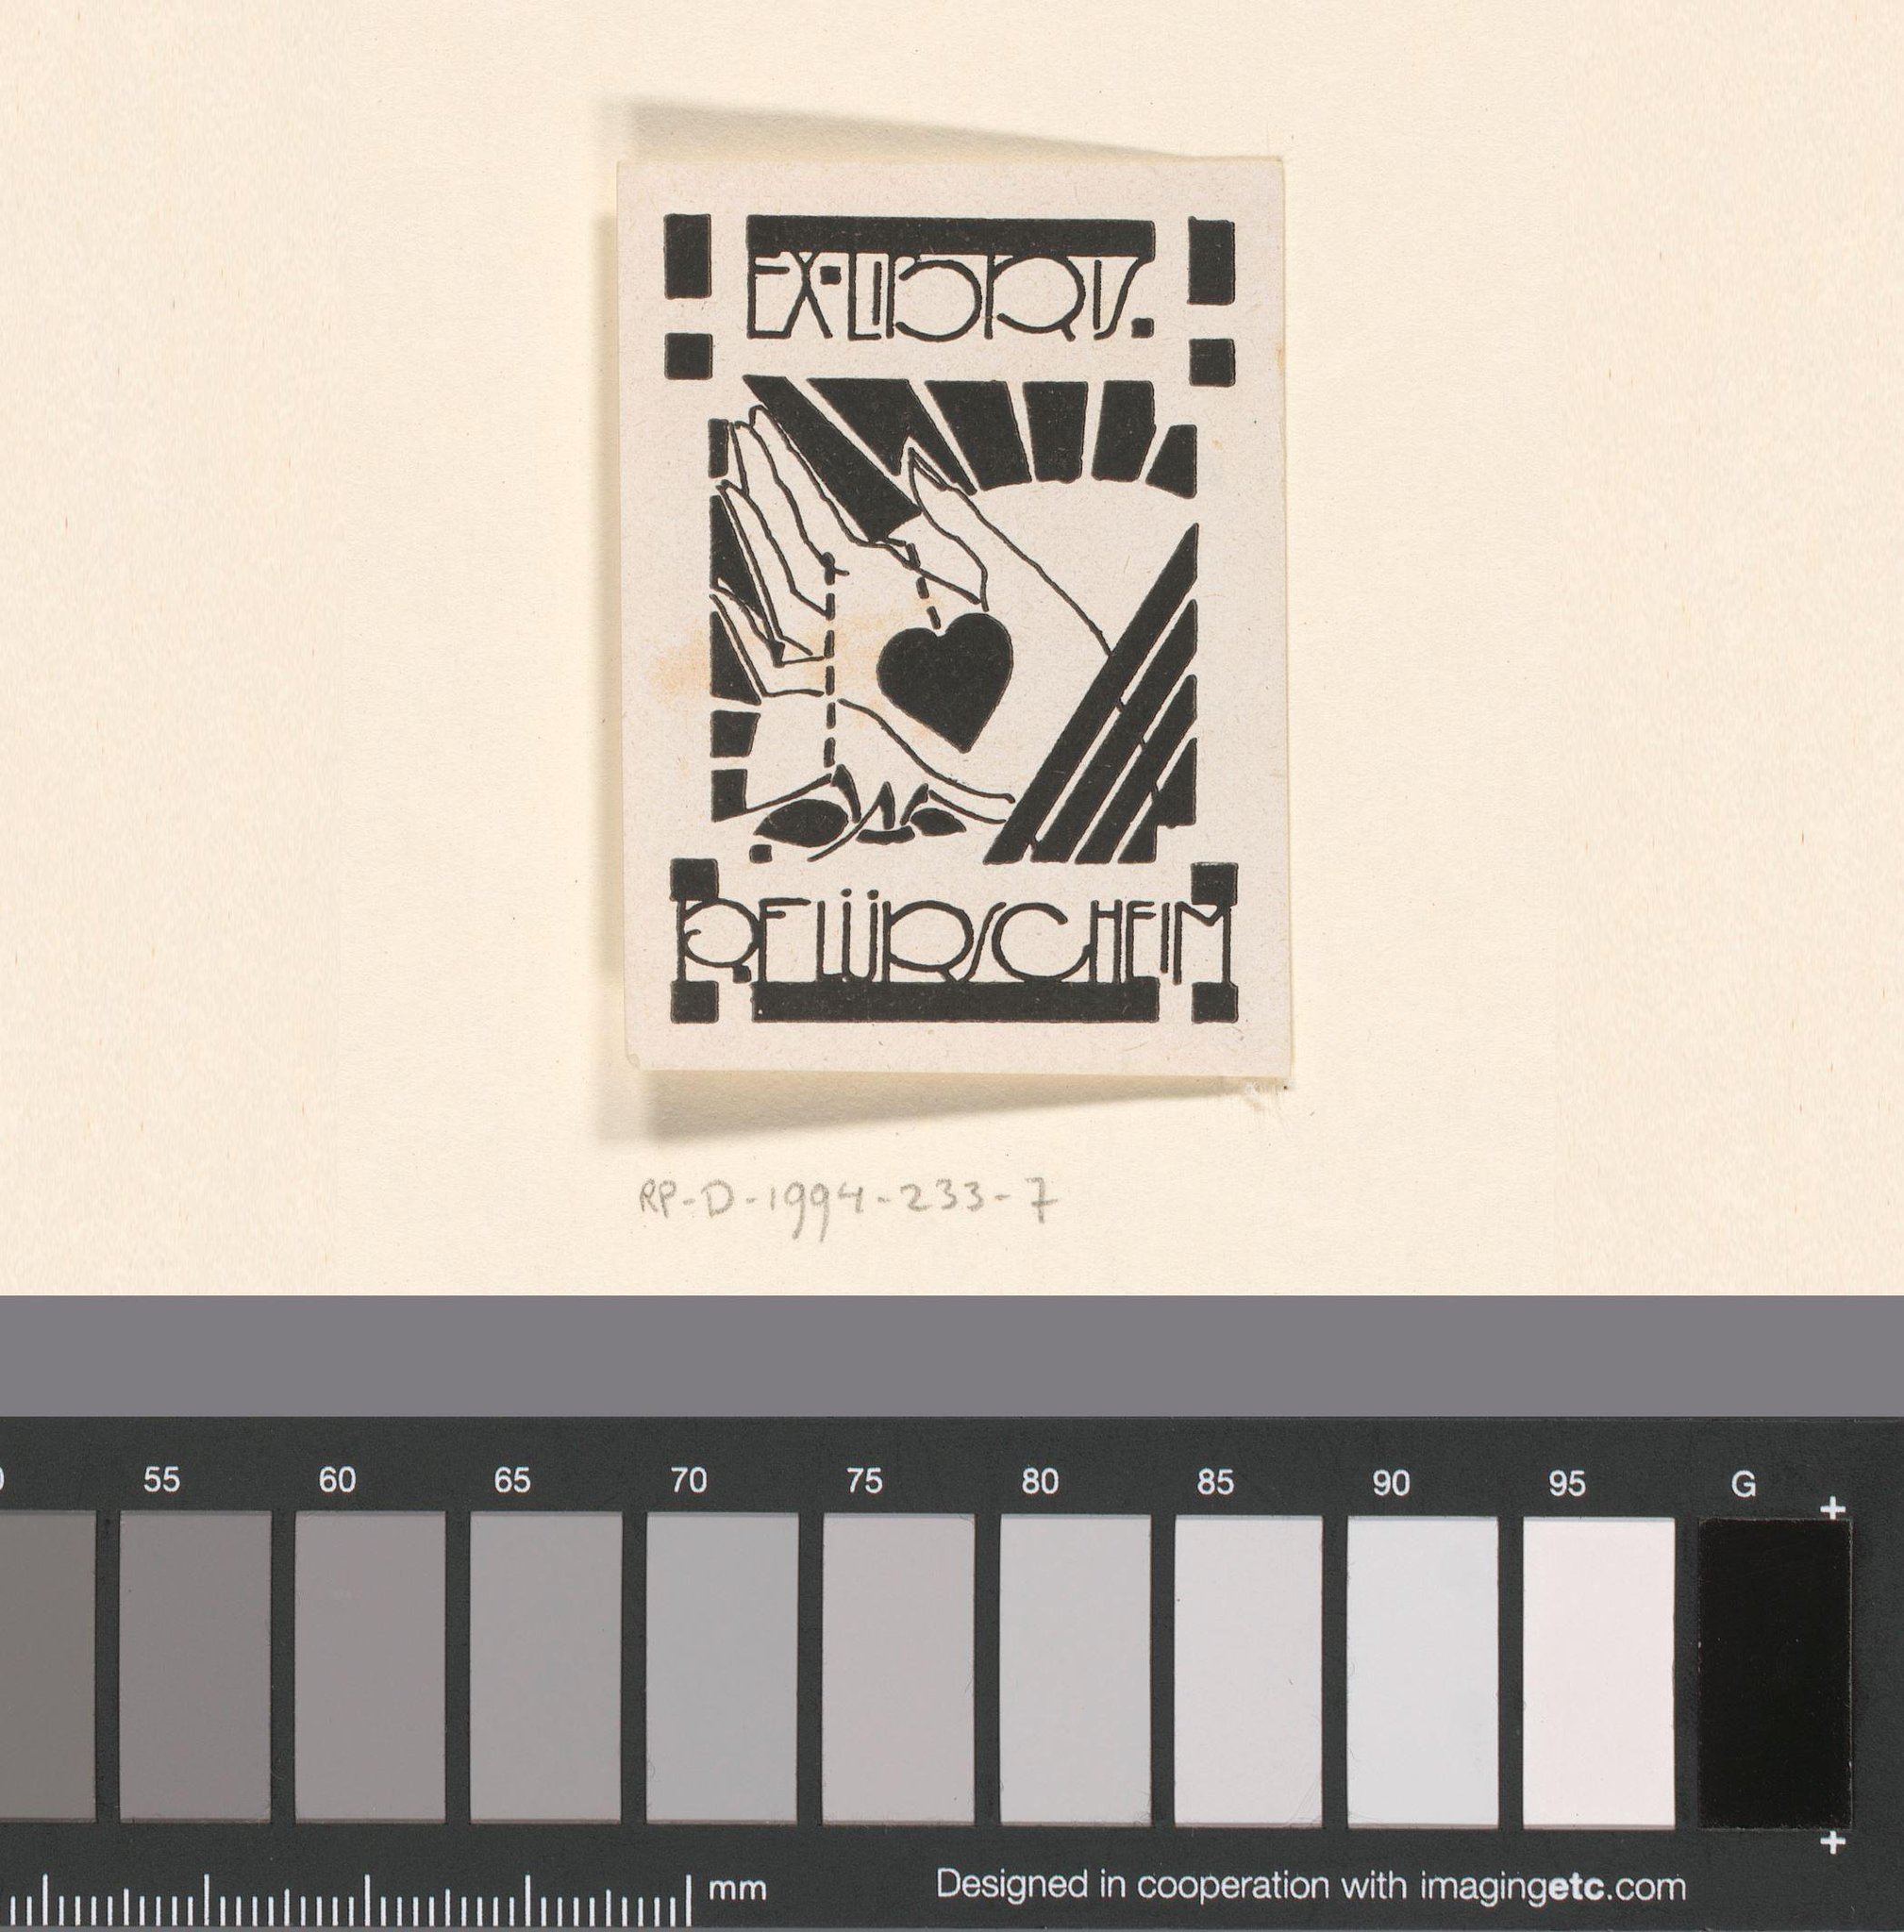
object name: print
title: Ex libris van P. Flürscheim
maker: reijer stolk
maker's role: draughtsman, print maker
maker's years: 1896-1945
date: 1906-1945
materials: paper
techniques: woodcut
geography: netherlands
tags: necklace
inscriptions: collector's mark: Lugt 2228, collector's mark: Lugt 2760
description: In het midden een open hand met daarin een ketting met een hart eraan.